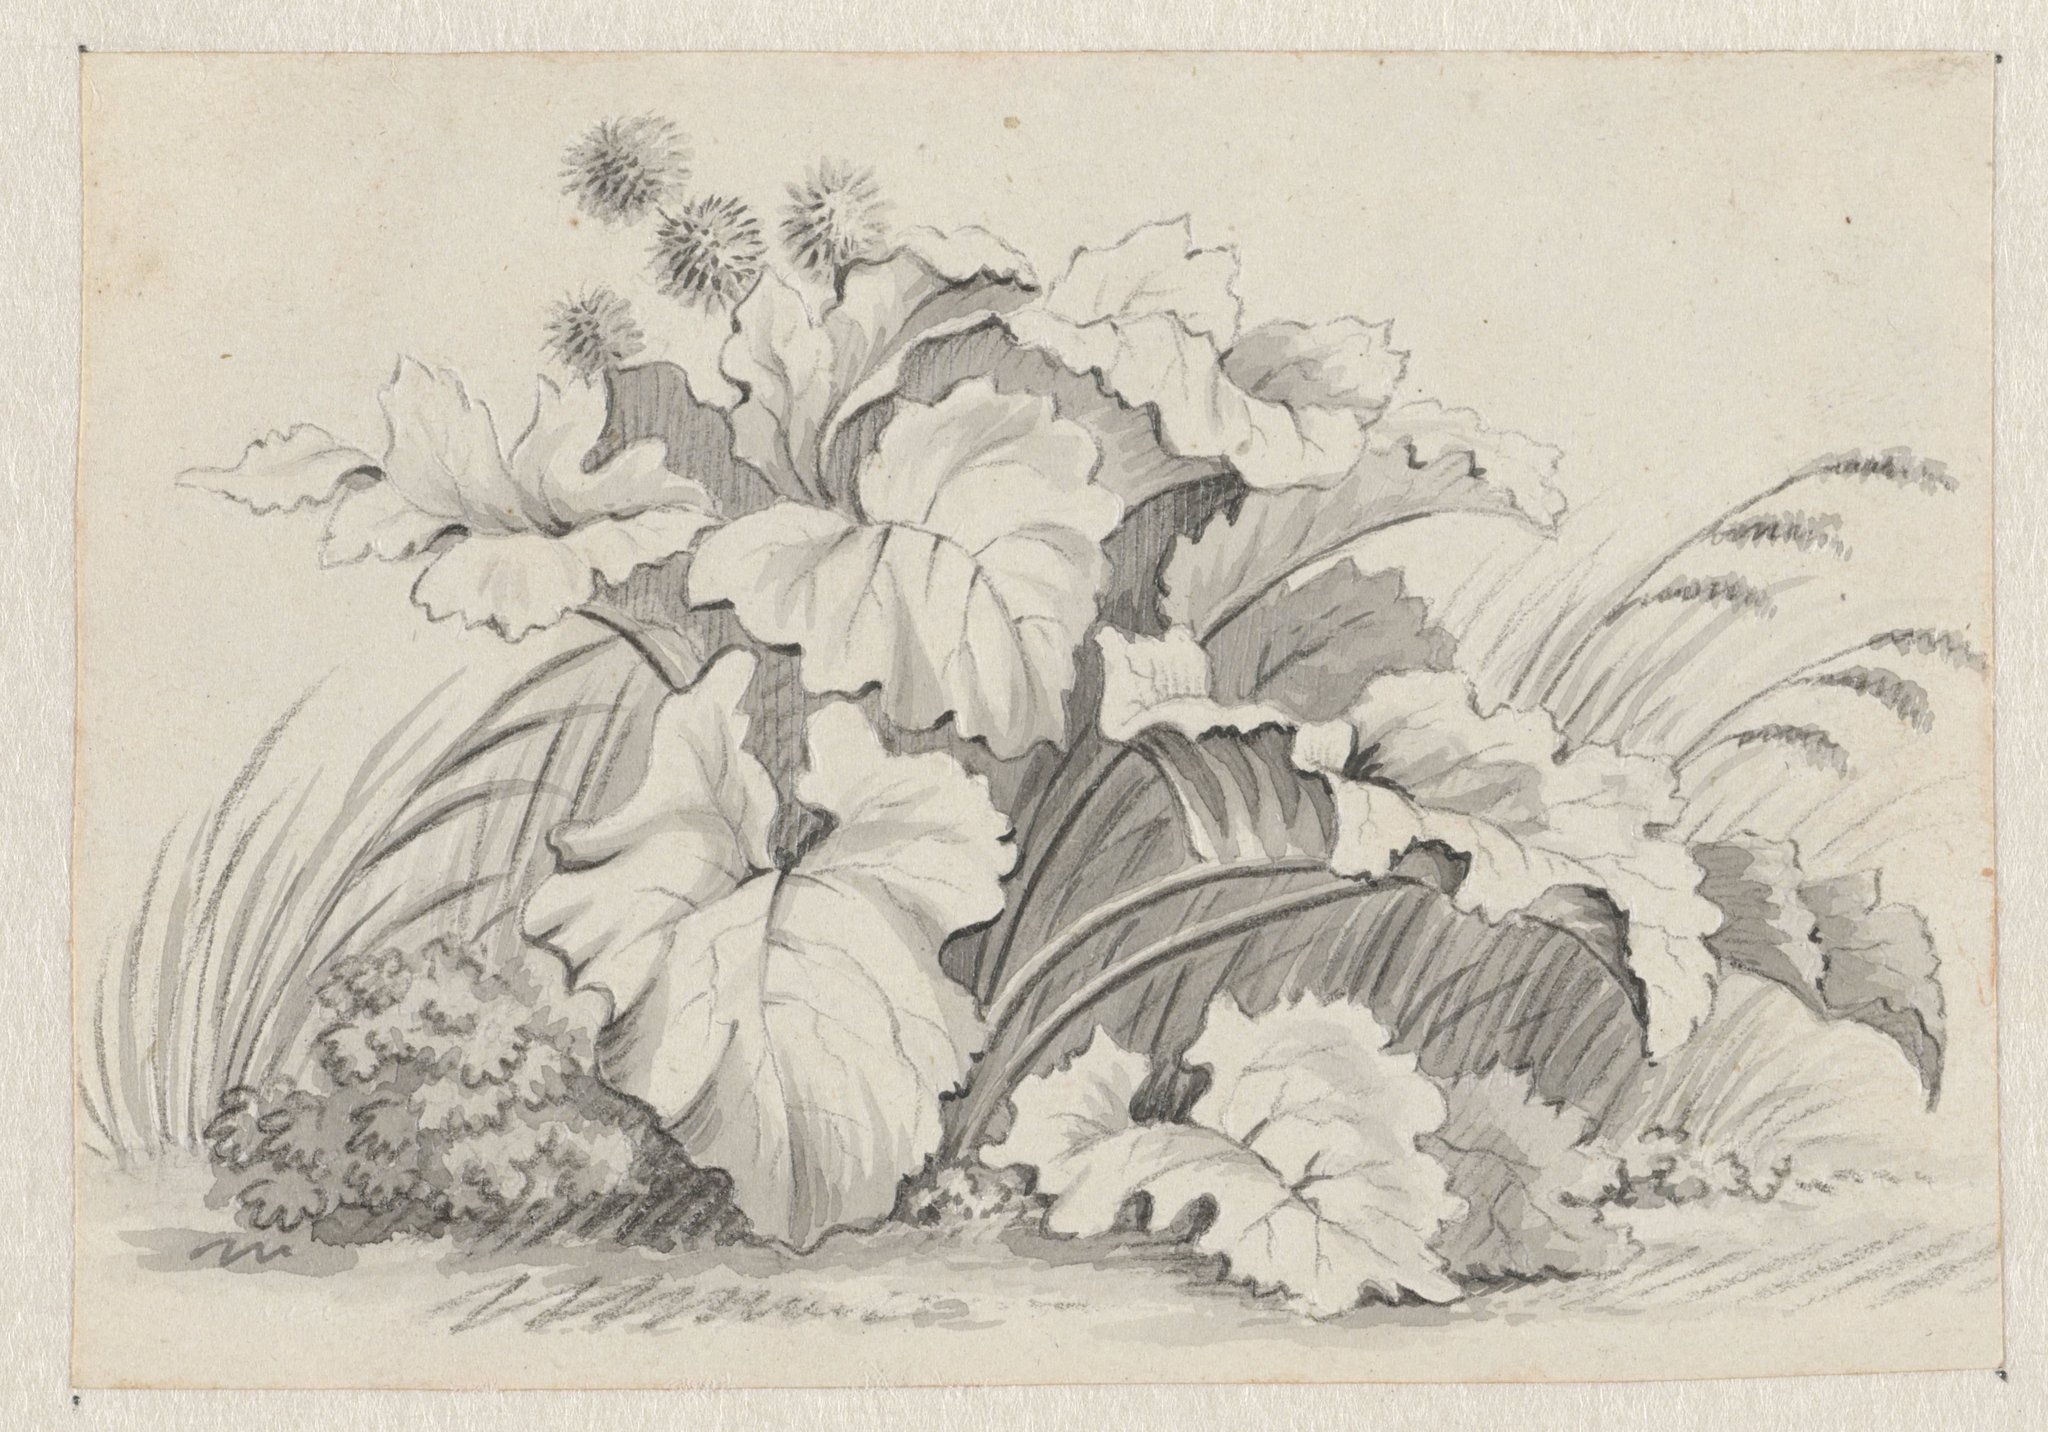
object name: design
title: Plantenstudie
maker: pieter de goeje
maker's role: draughtsman, print maker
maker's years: 1789-1859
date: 1789-1859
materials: chalk, paper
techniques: brush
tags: plants and herbs